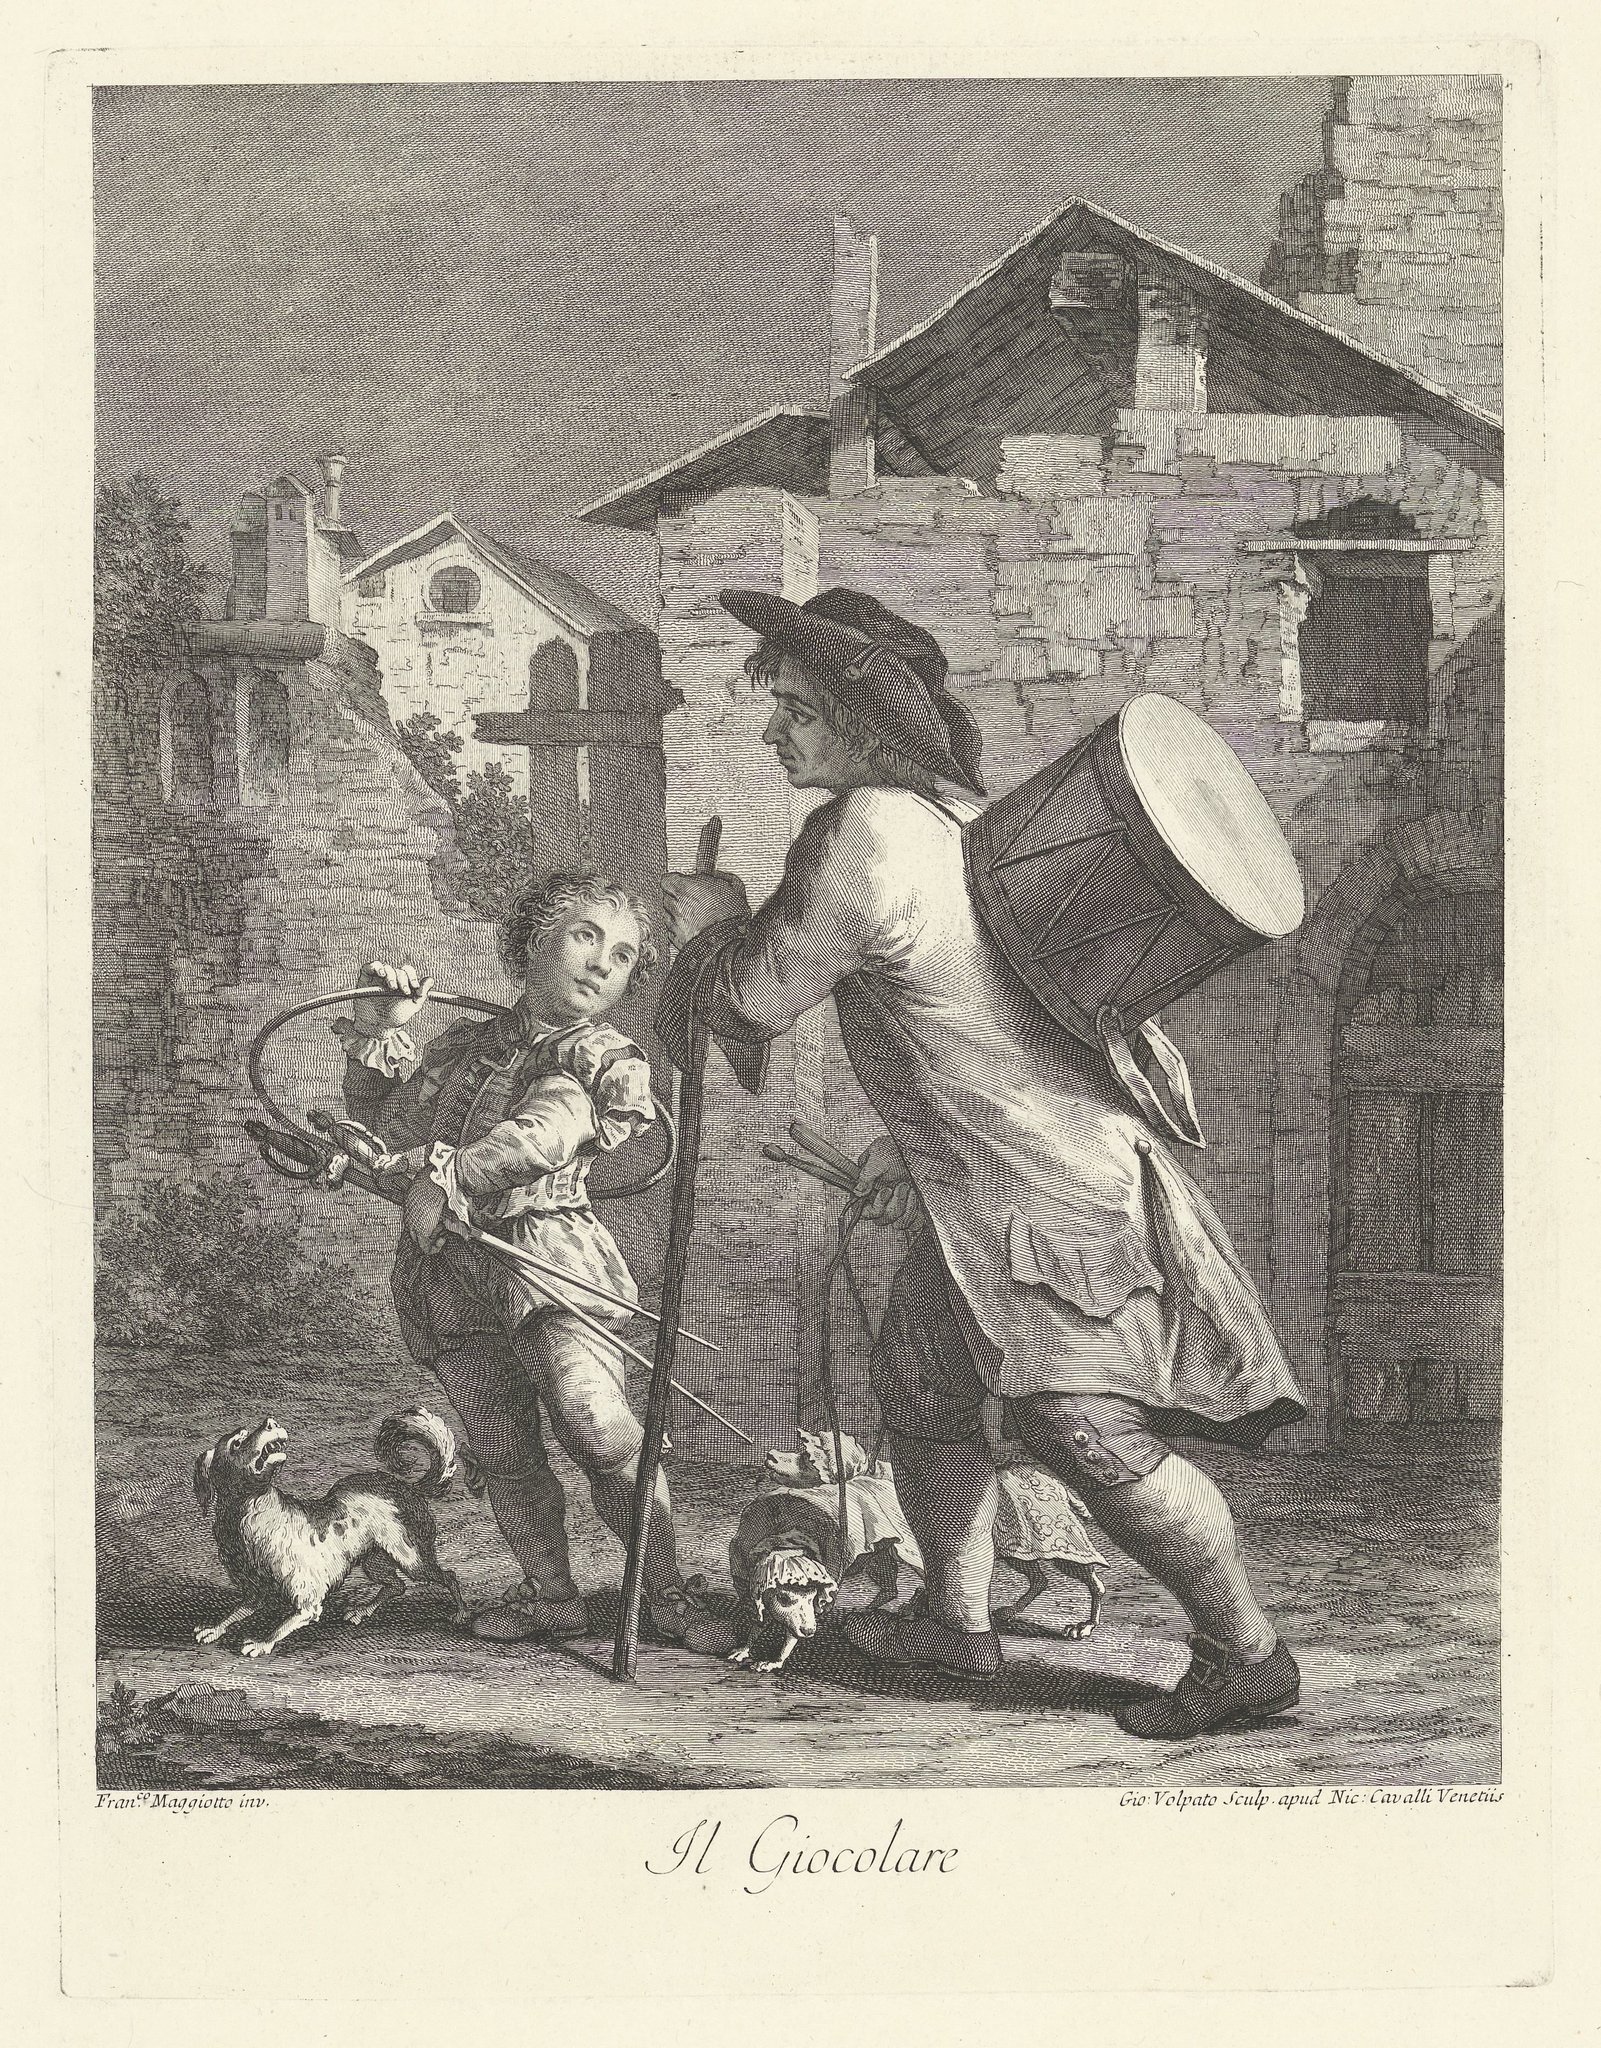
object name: print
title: De straatartiest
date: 1743-1803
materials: paper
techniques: engraving, etching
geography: venice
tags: musical instruments; group of musical instruments, one person playing an instrument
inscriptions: collector's mark: Lugt 2228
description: Een straatartiest met muziekinstrumenten en hondjes. Voor hem een knaap met degens en een hoepel.